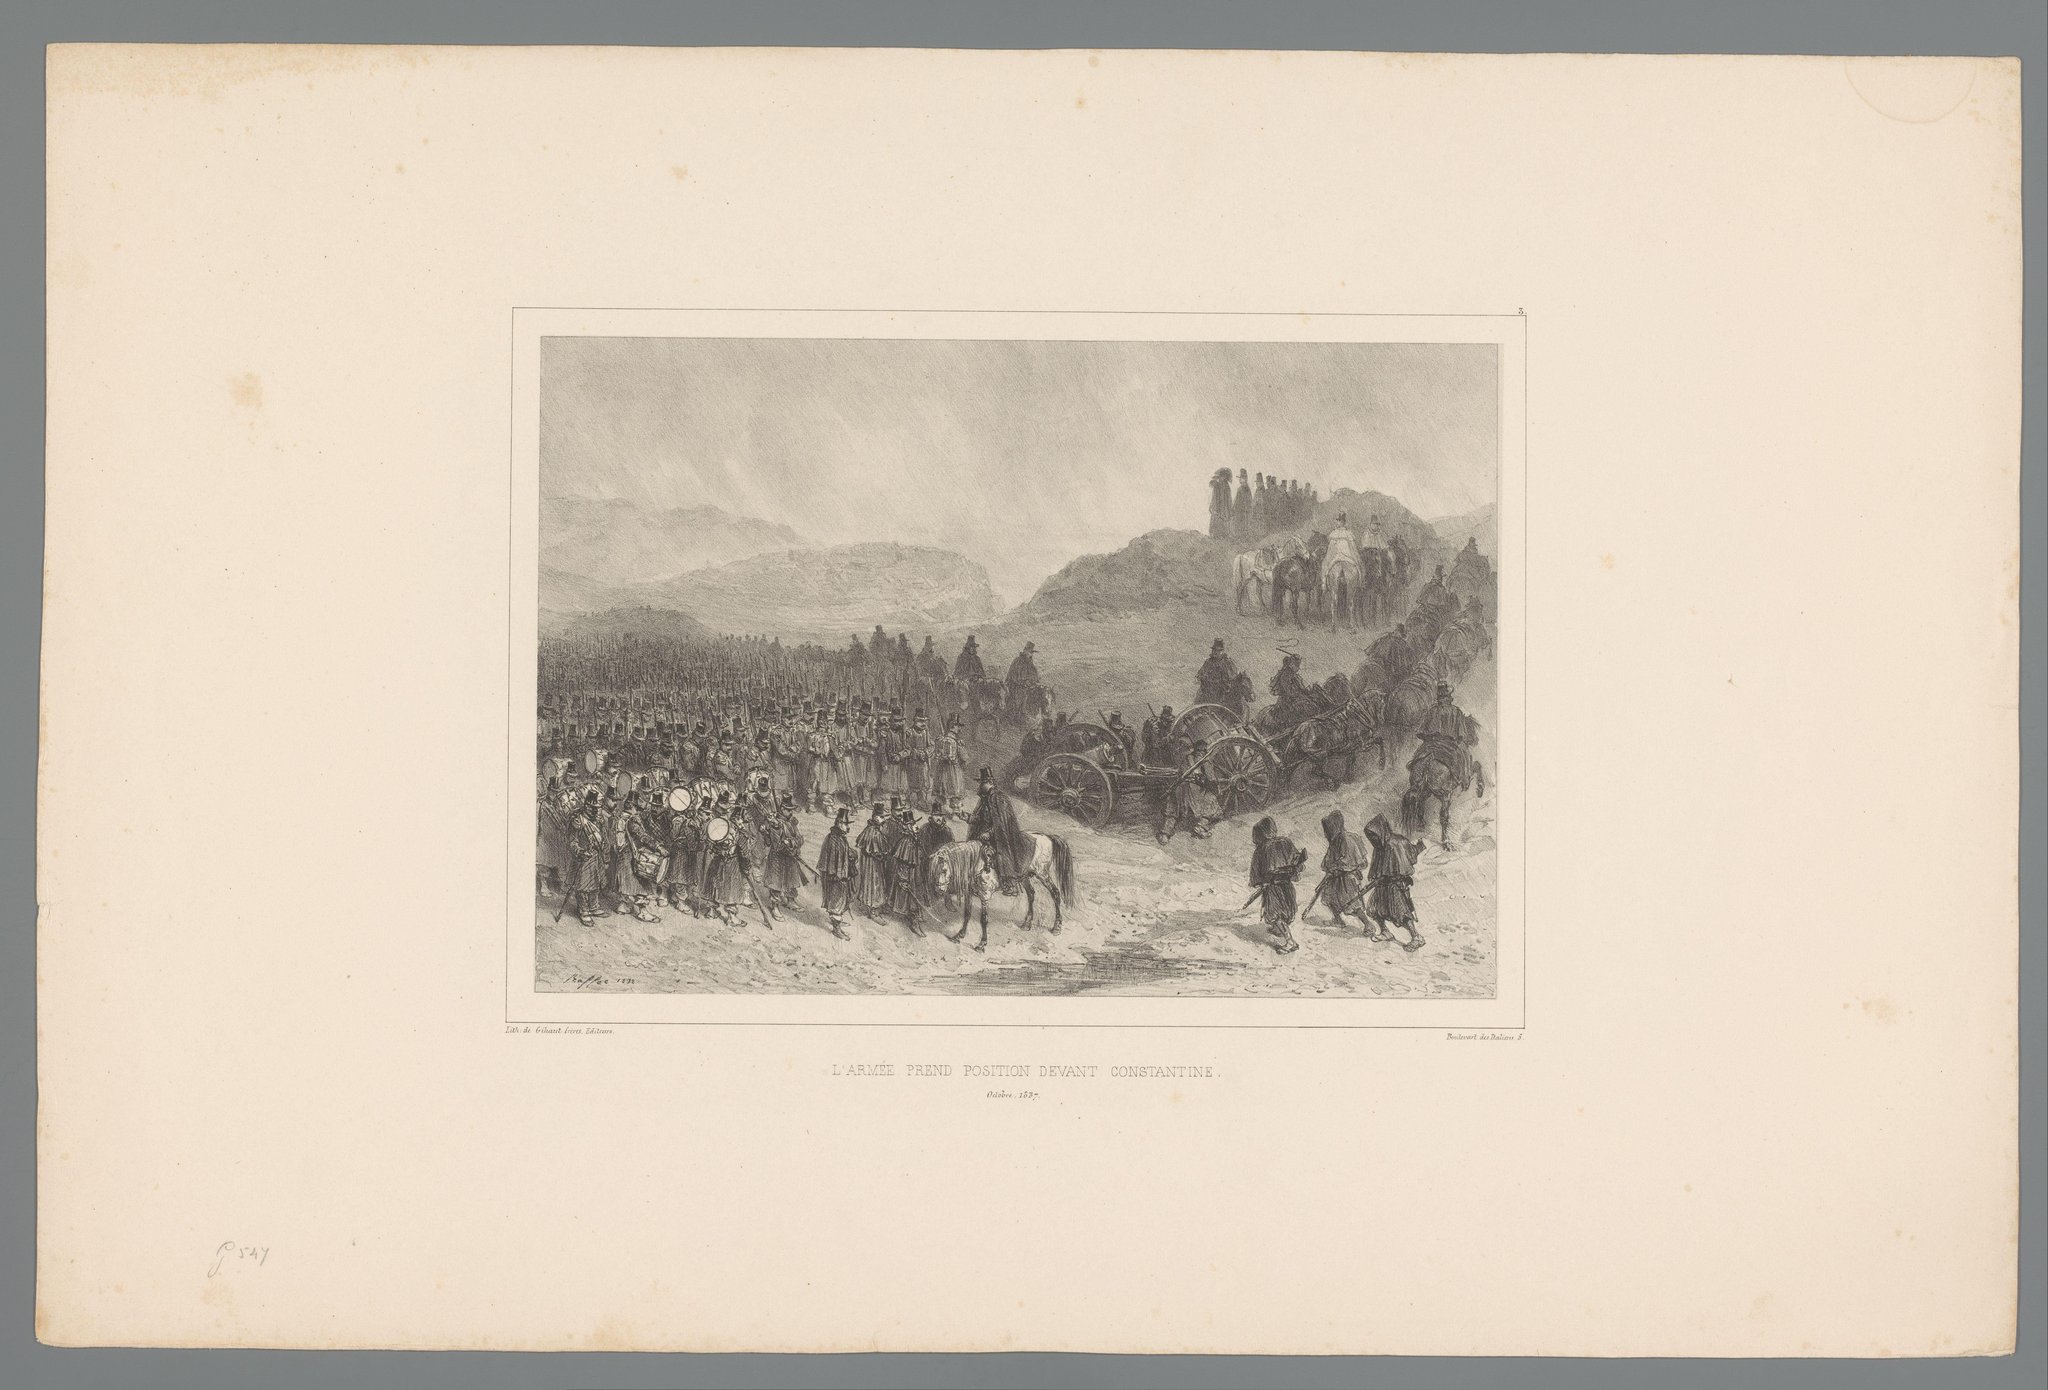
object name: print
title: L'armée prend position devant Constantine. Octobre, 1837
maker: denis auguste marie raffet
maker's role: draughtsman, print maker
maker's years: 1804-1860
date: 1838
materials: paper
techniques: lithograph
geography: paris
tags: firearms: cannon, the soldier; the soldier's life, division of armed forces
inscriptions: collector's mark: Lugt 2228